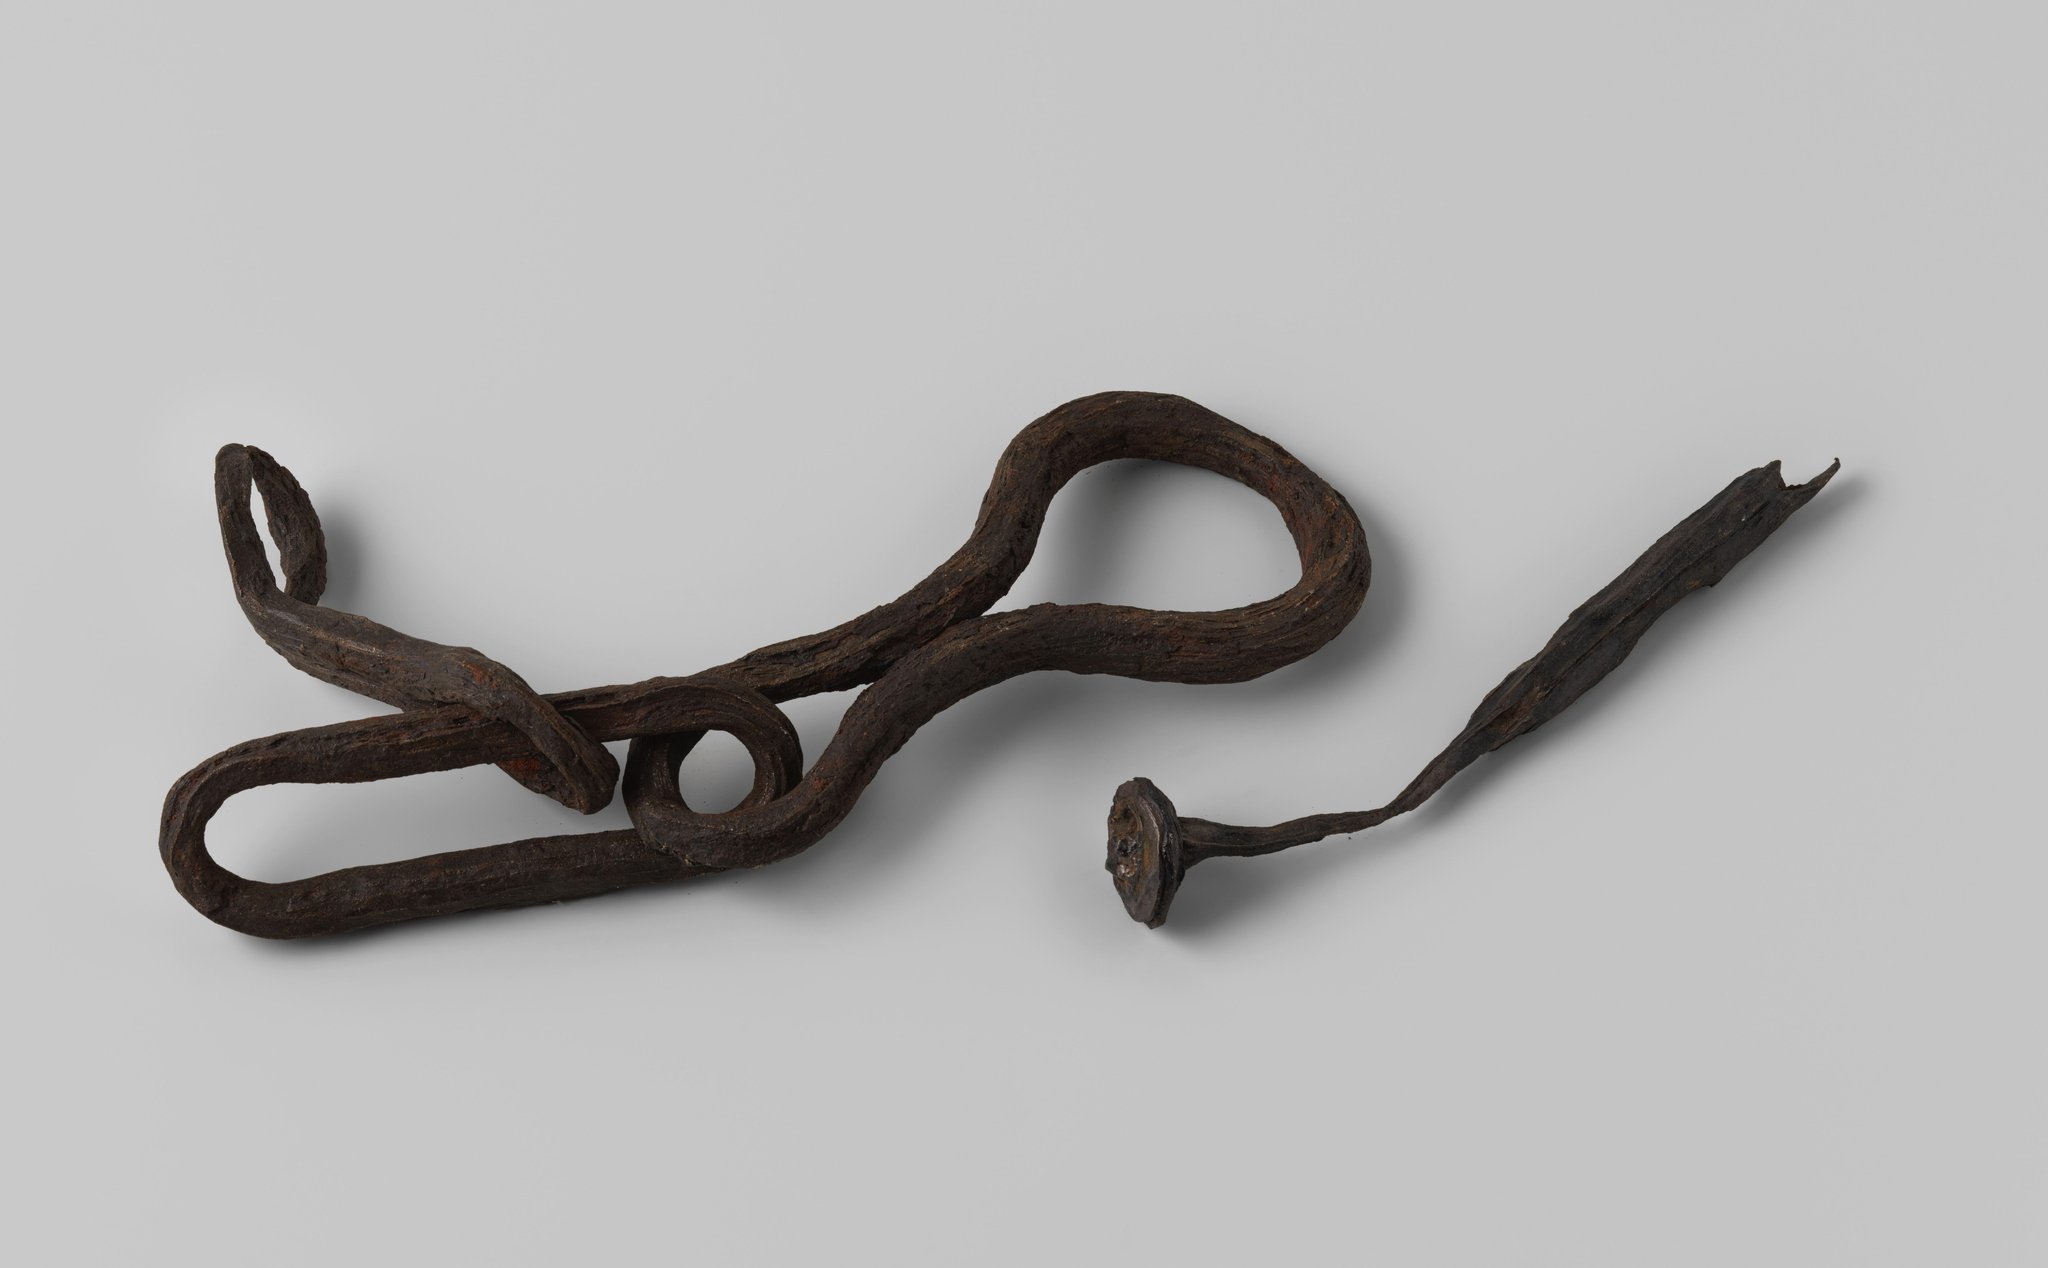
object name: rustijzer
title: Rustijzer met bout uit het wrak van de Oost-Indiëvaarder Princesse Maria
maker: Anonymous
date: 1682-1686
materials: iron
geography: middelburg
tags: princesse maria (schip), verenigde oostindische compagnie, scilly-eilanden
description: Drie gietijzeren schakels waarvan éen niet sluitend van verschillende vorm en een sluitbout met ronde kop. Dit rustijzer of puttingijzer met bout diende ter bevestiging van het want aan verschansing of de mars van een schip. Chain and bolt.